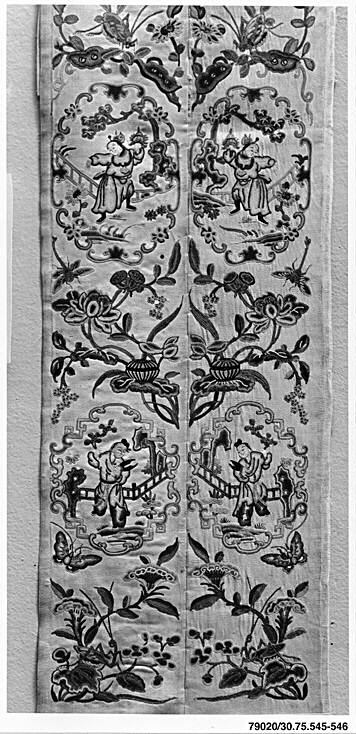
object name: sleeve band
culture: chinese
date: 1801-1900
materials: metal thread, silk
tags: human figures,flowers